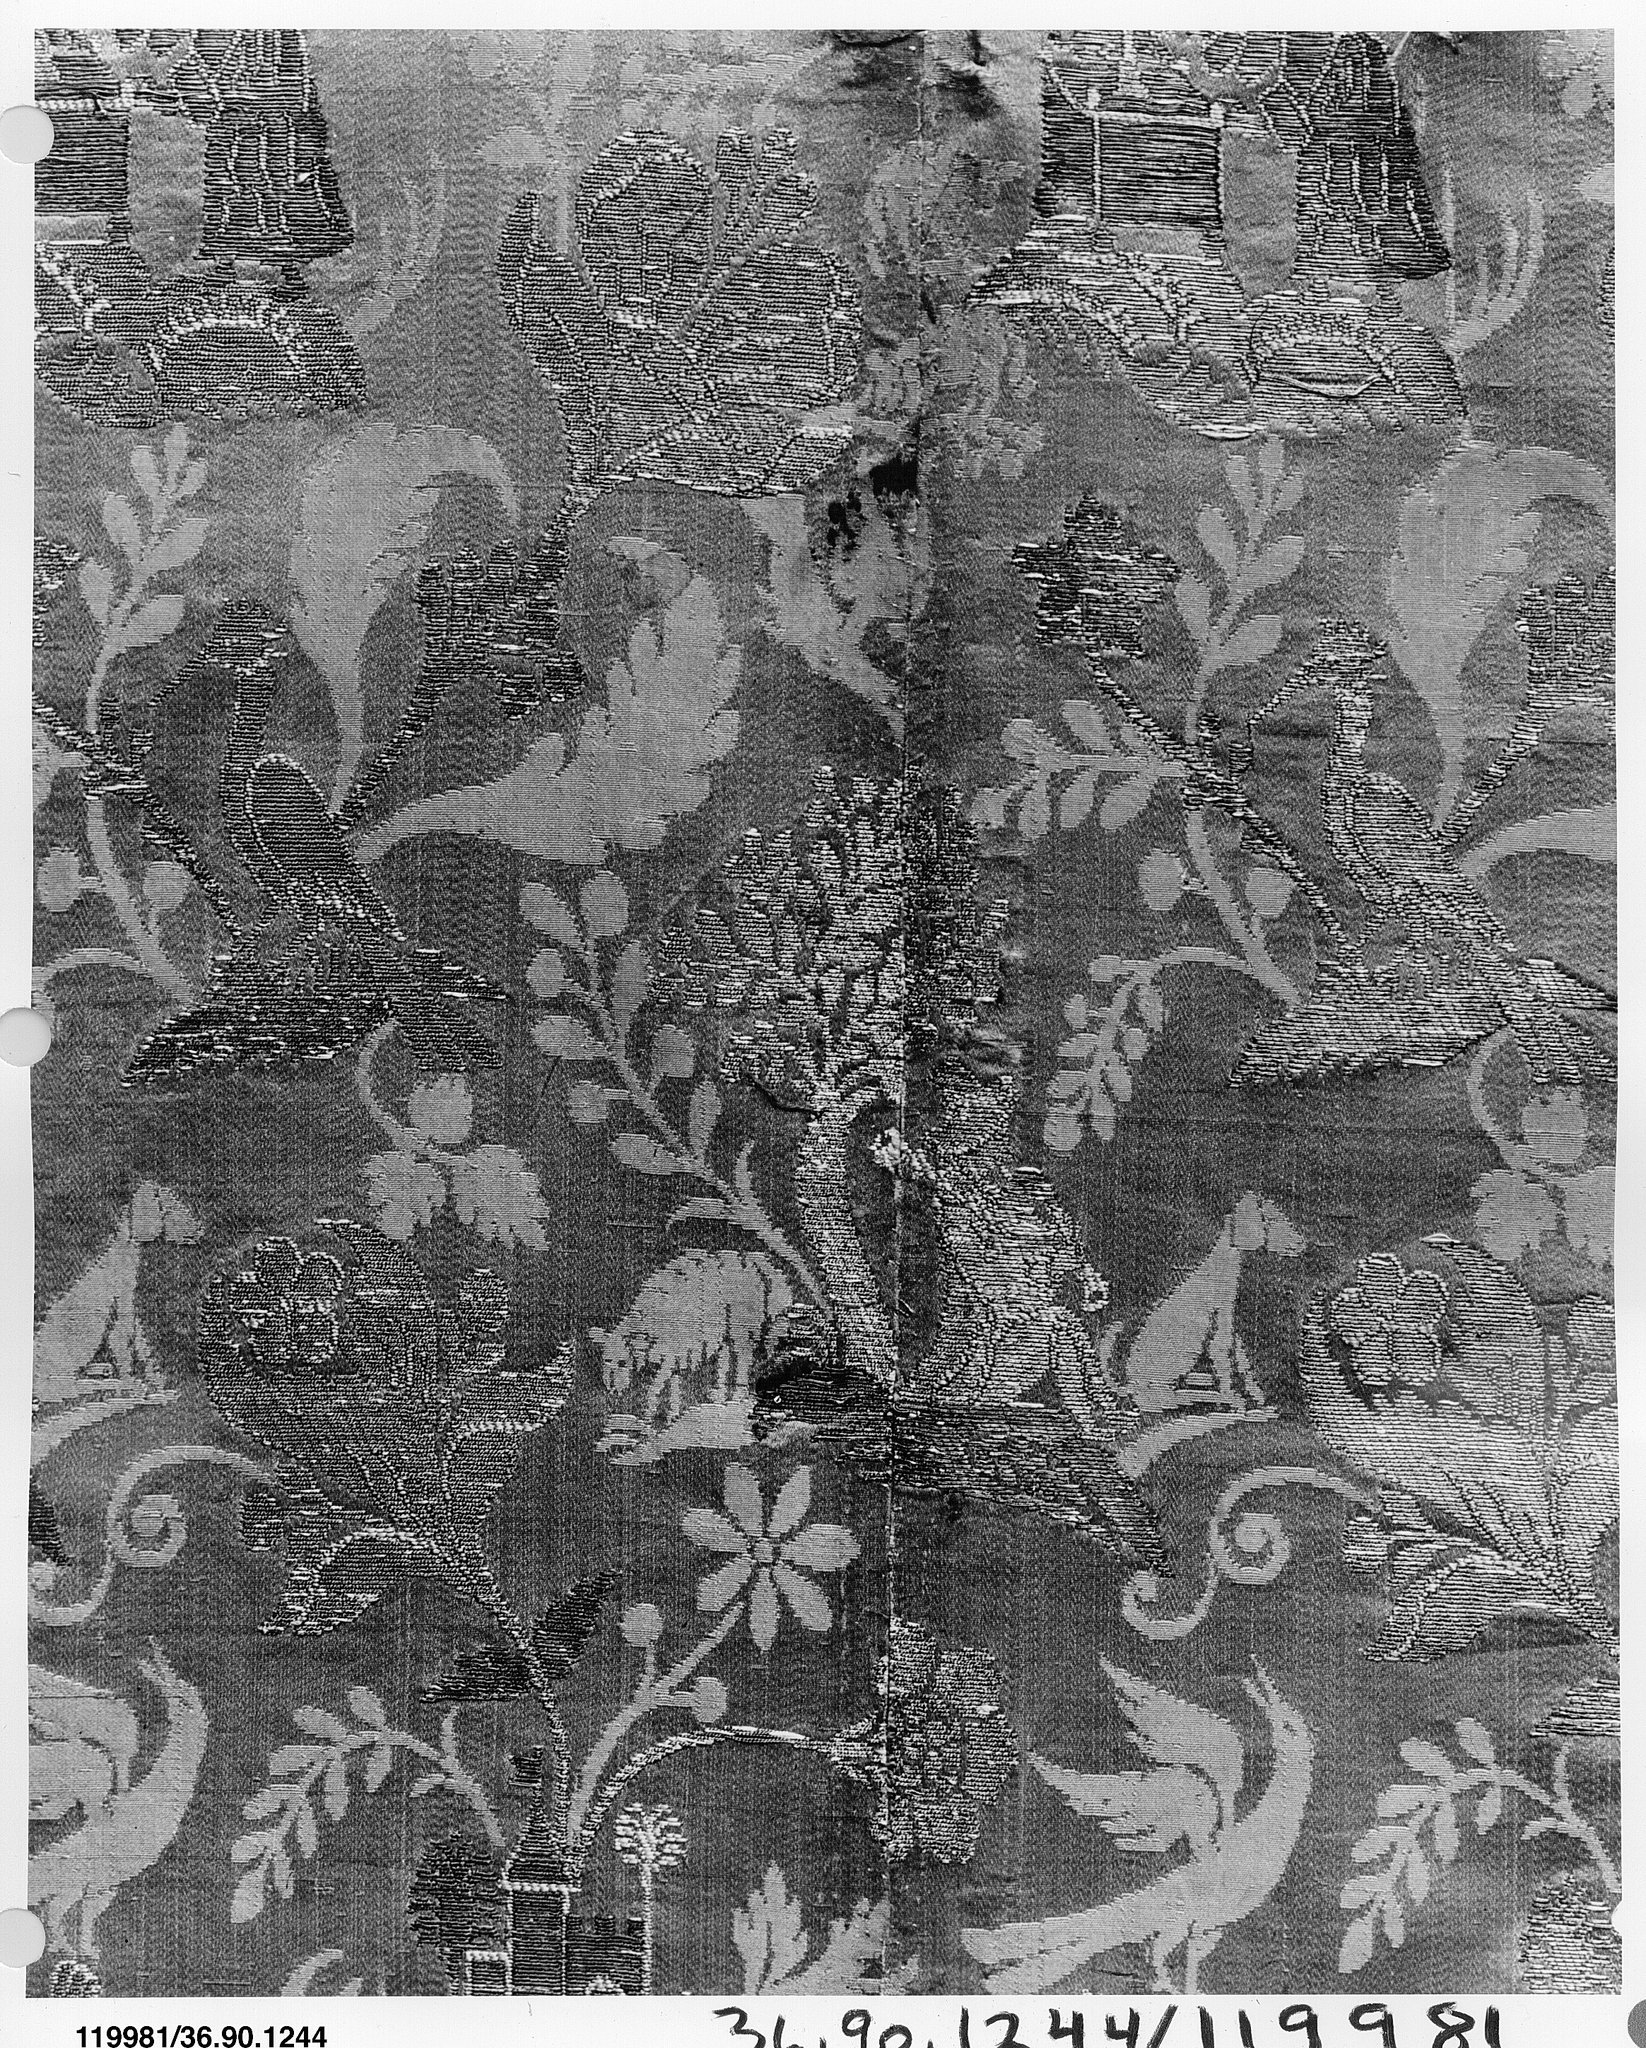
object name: piece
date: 1700-1715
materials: metal thread, silk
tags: human figures,birds,castles,dogs,sheep,flowers,leaves